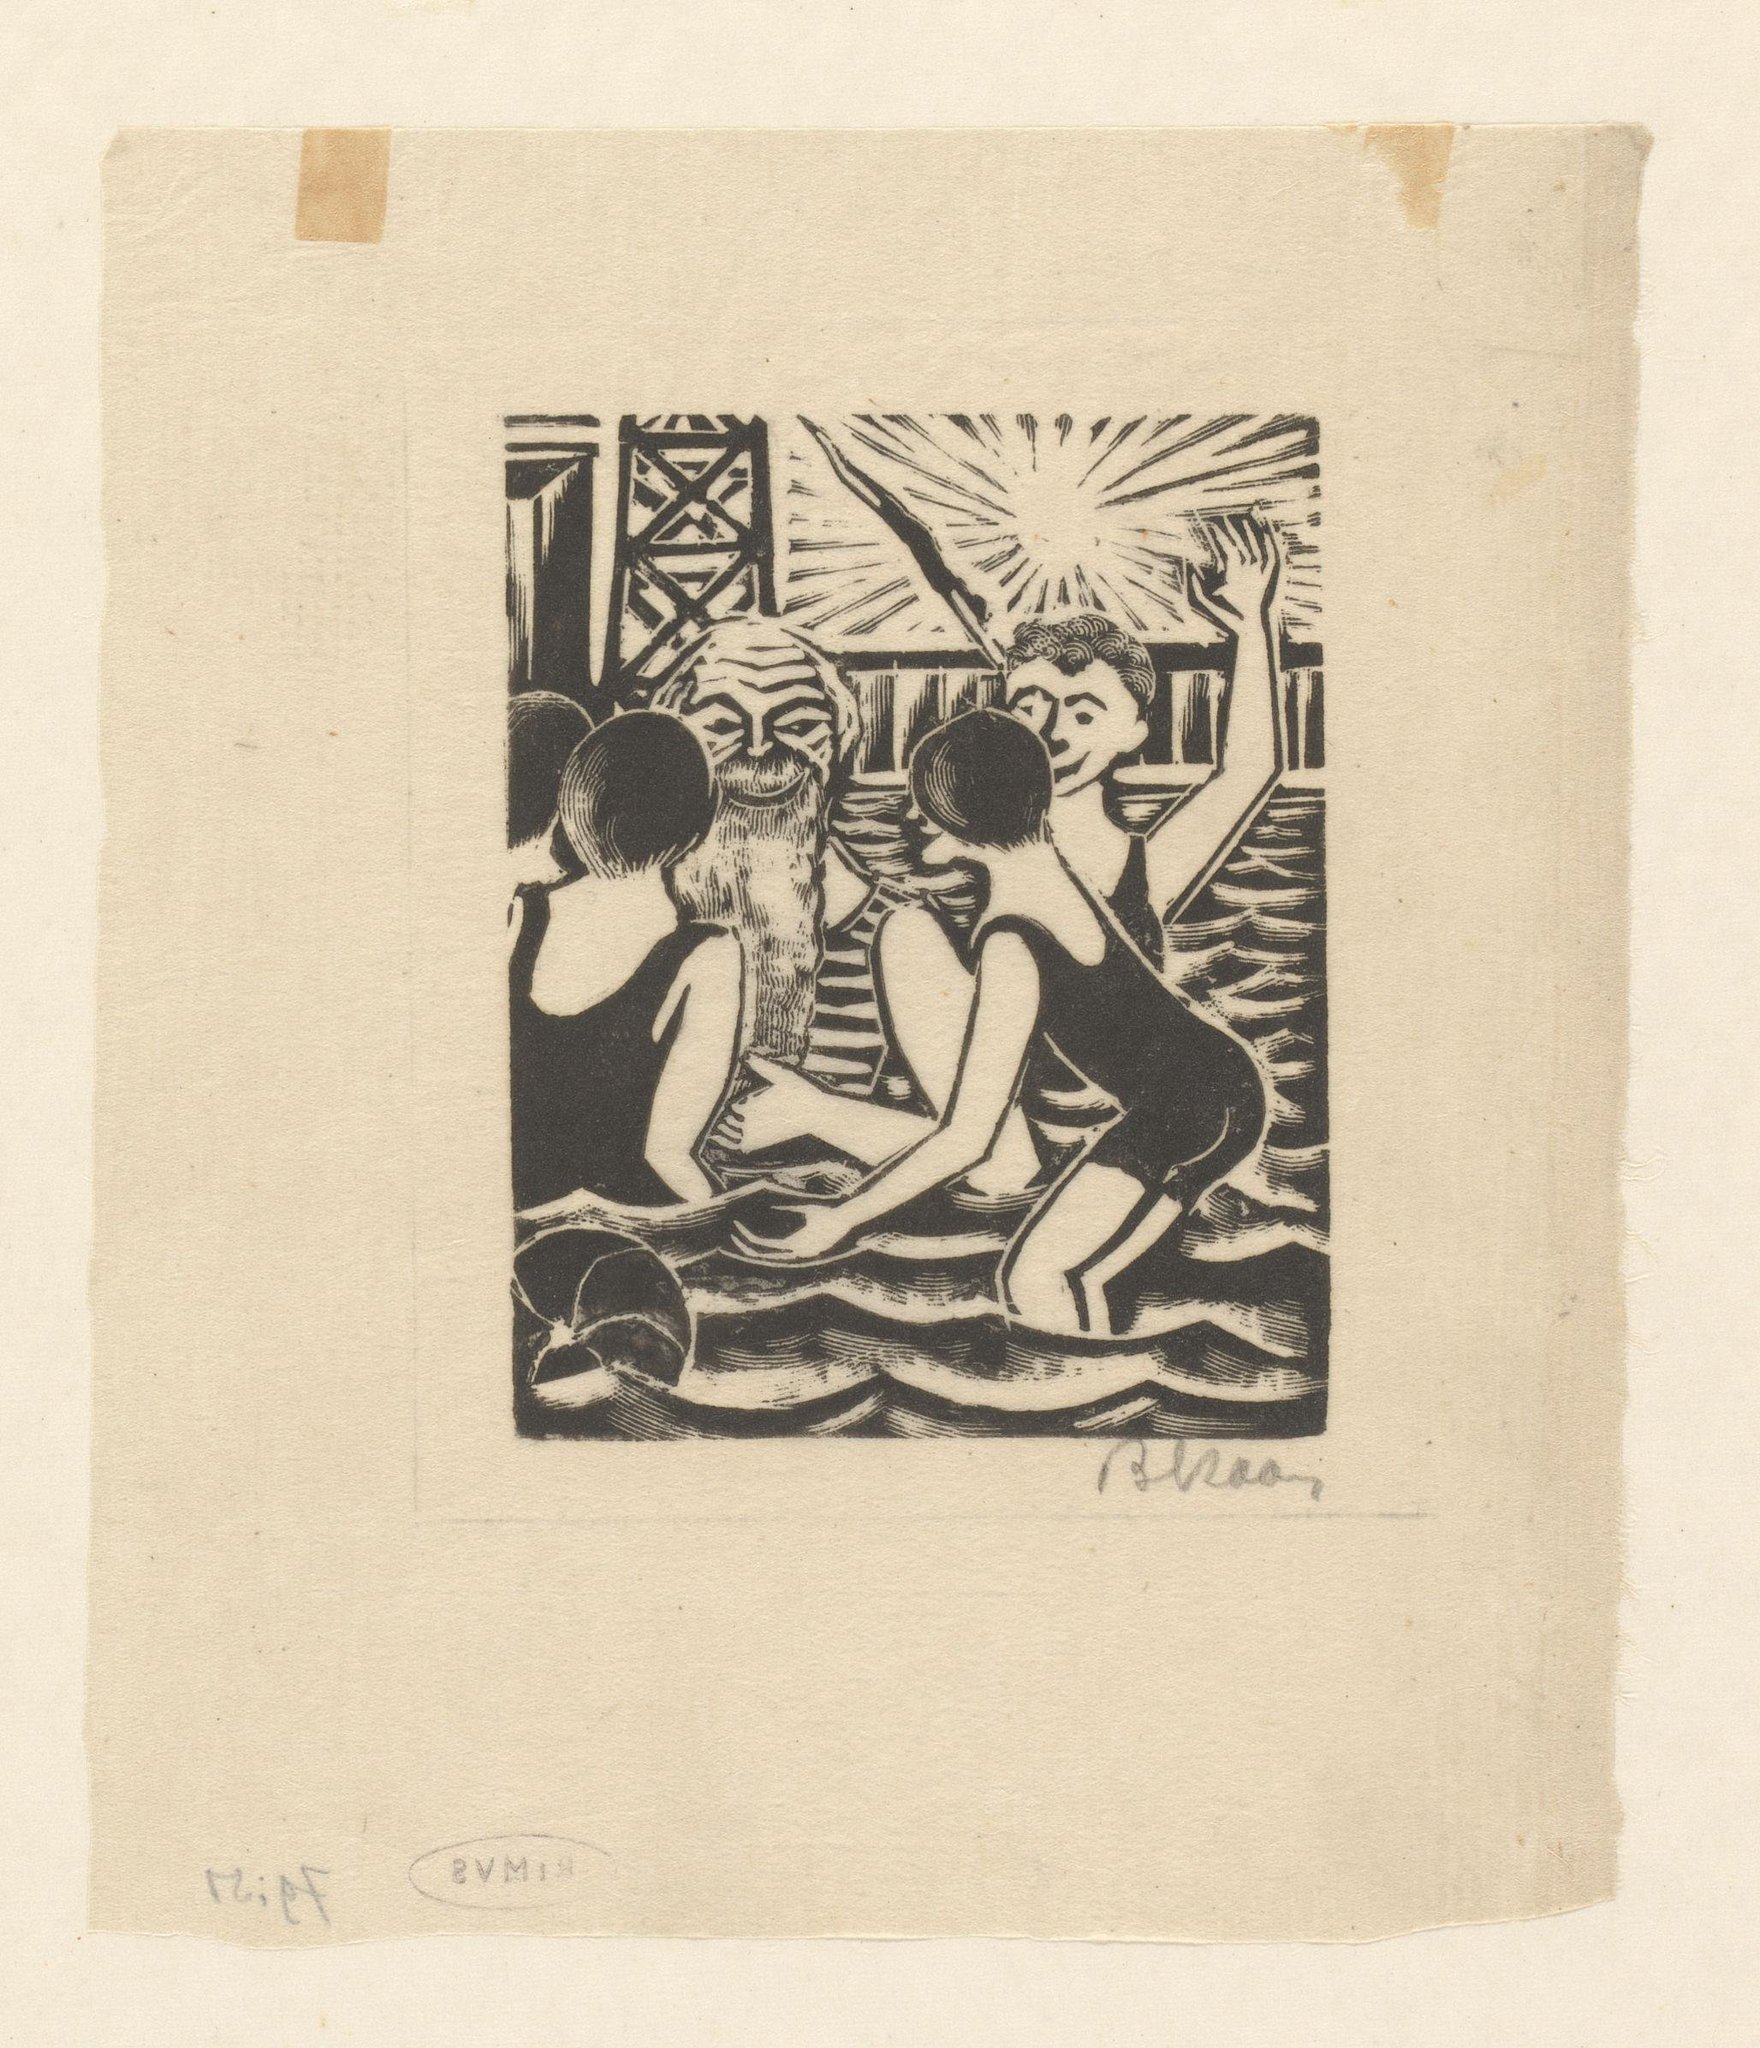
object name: print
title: Sinterklaas in het zwembad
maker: jo bezaan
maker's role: draughtsman, print maker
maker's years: 1894-1952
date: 1941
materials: paper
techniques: engraving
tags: festivities on st. nicholas (eve) (december 5), swimming (movement in water), pond, pool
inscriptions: collector's mark: Lugt 2228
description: Deze prent was bestemd voor: Hattum, Jac. van. Van Odrimond, Millimas en anderen. Putten: D.J. Terwee, [1941]. De prent is echter nooit in de publicatie opgenomen.